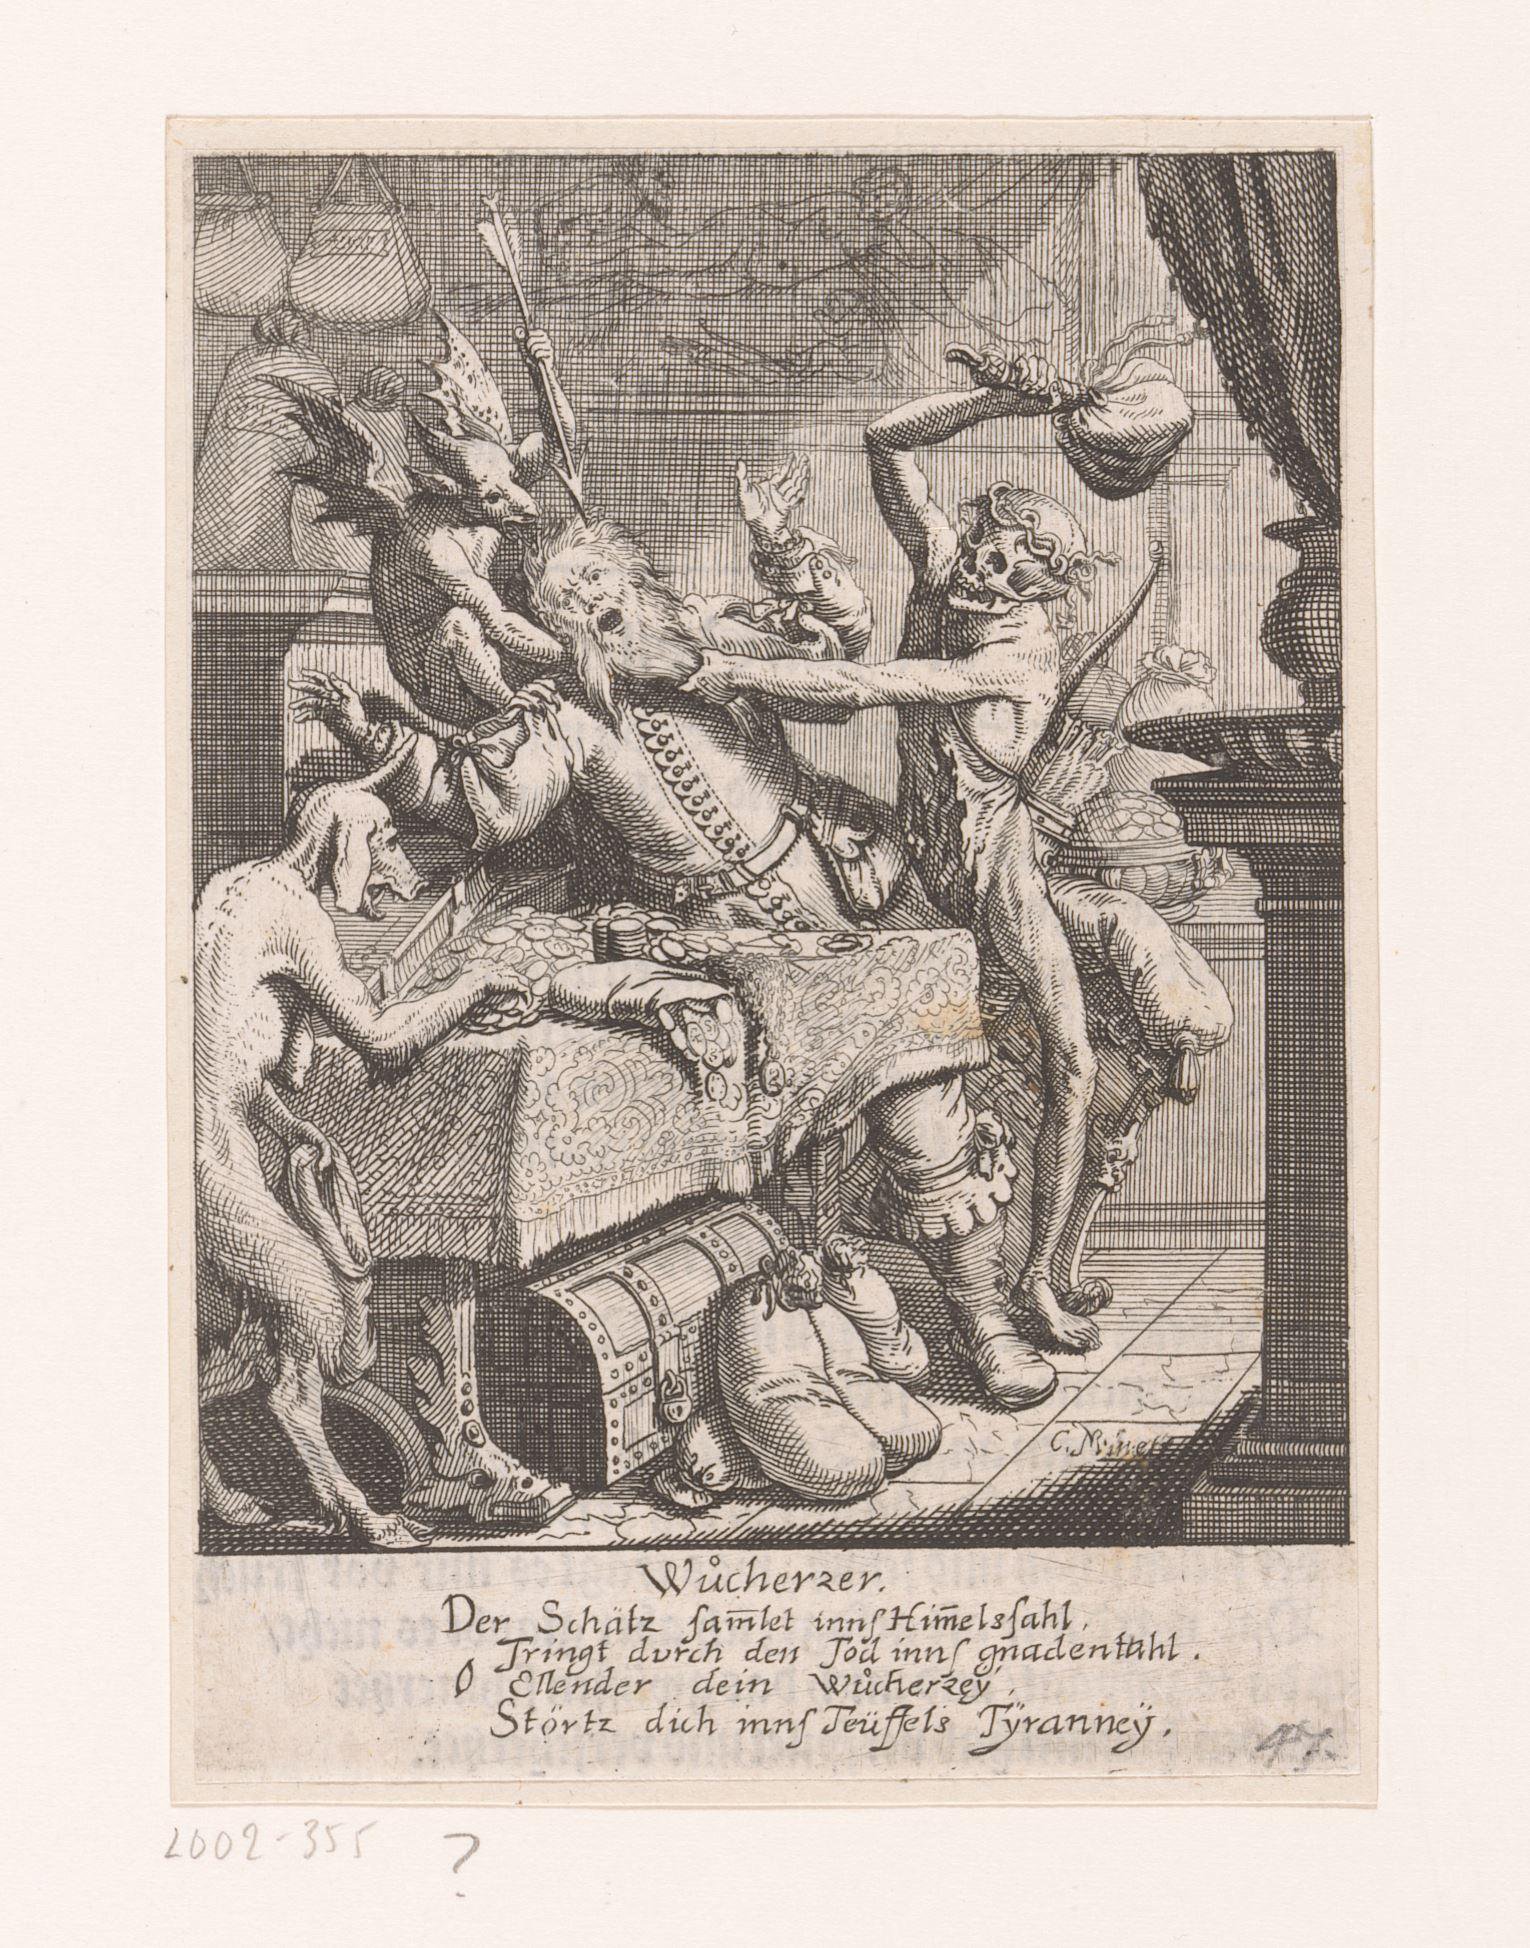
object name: print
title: De Dodendans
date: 1650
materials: paper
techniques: etching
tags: personifications of death; 'morte' (ripa), dance of death; death together with one or more human beings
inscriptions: collector's mark: Lugt 2233, collector's mark: Lugt 2228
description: Een woekeraar zit aan een tafel die overladen is met geld. Hij wordt gegrepen door monsters, waaronder de Dood als skelet. Een monster stopt geldstukken van tafel in een zak.